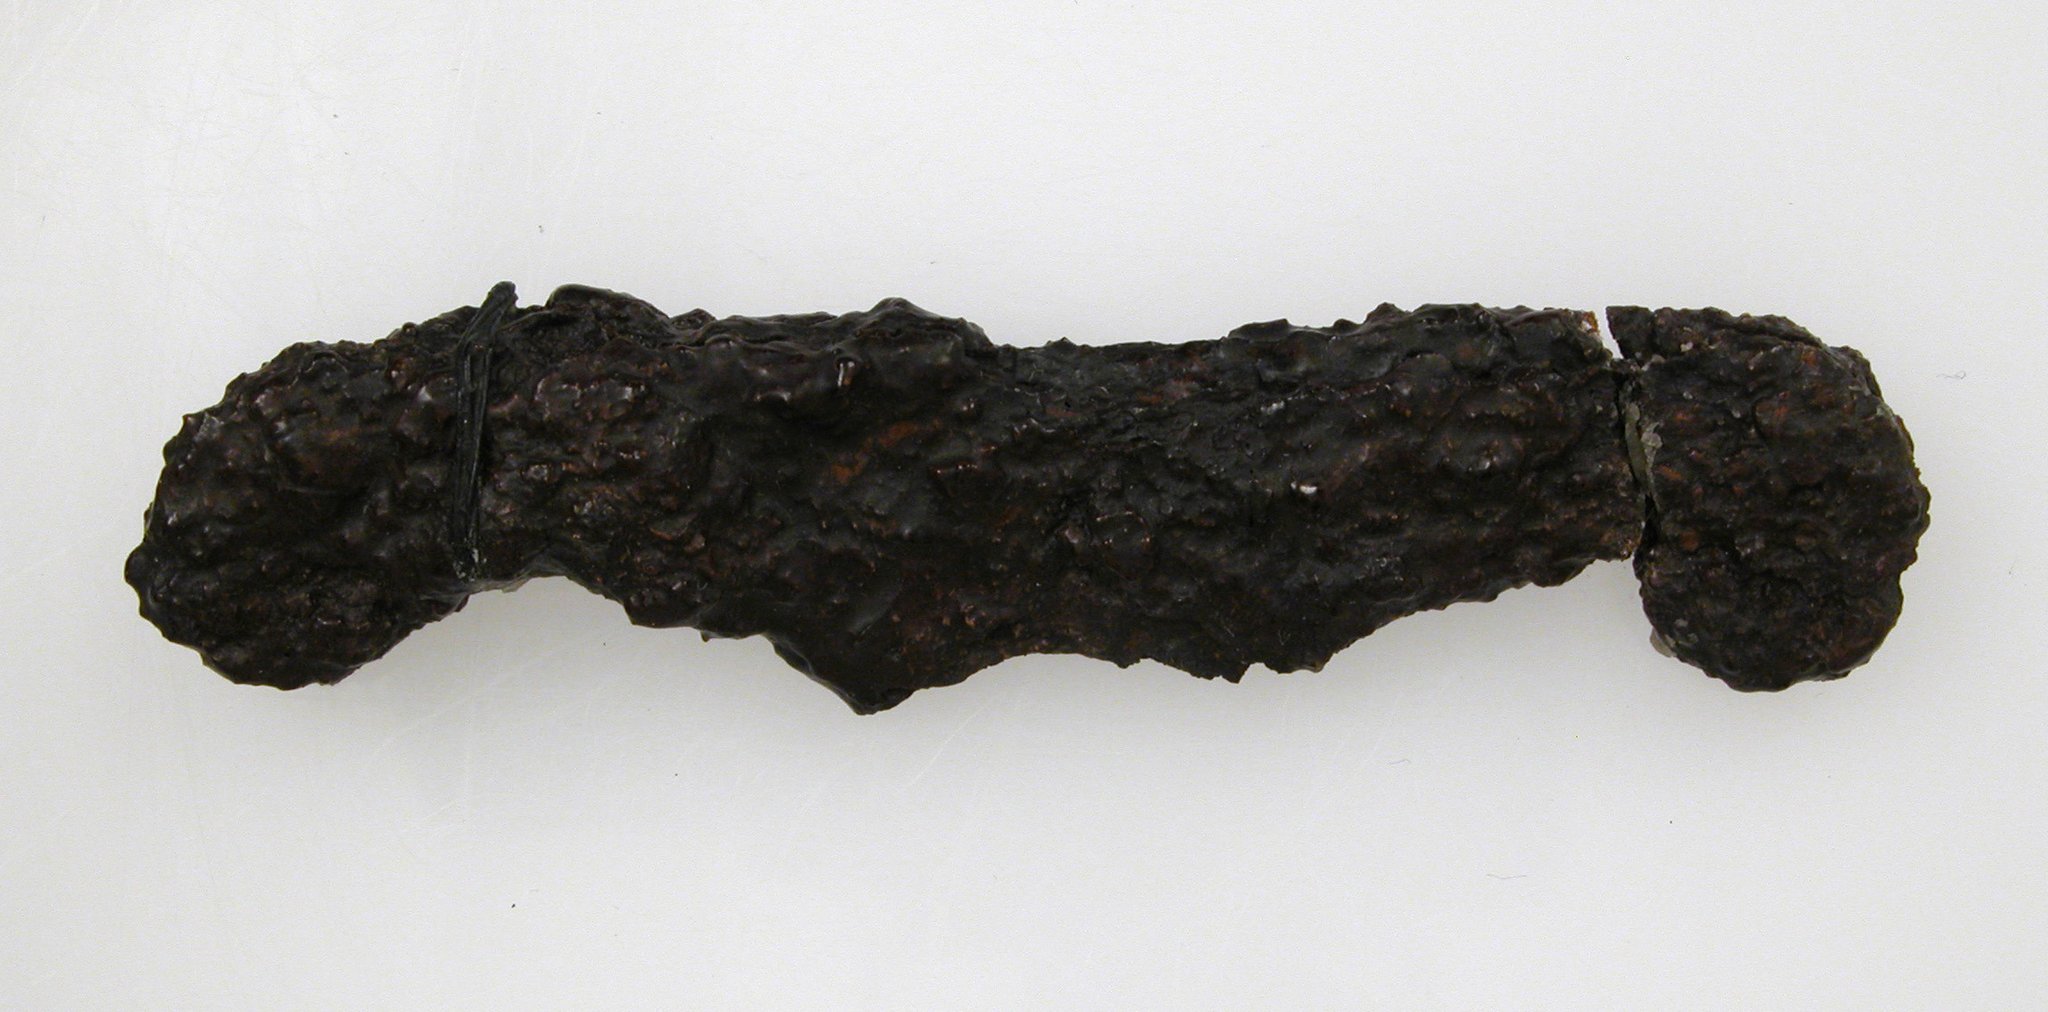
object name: mount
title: Fermoir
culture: frankish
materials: iron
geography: germany